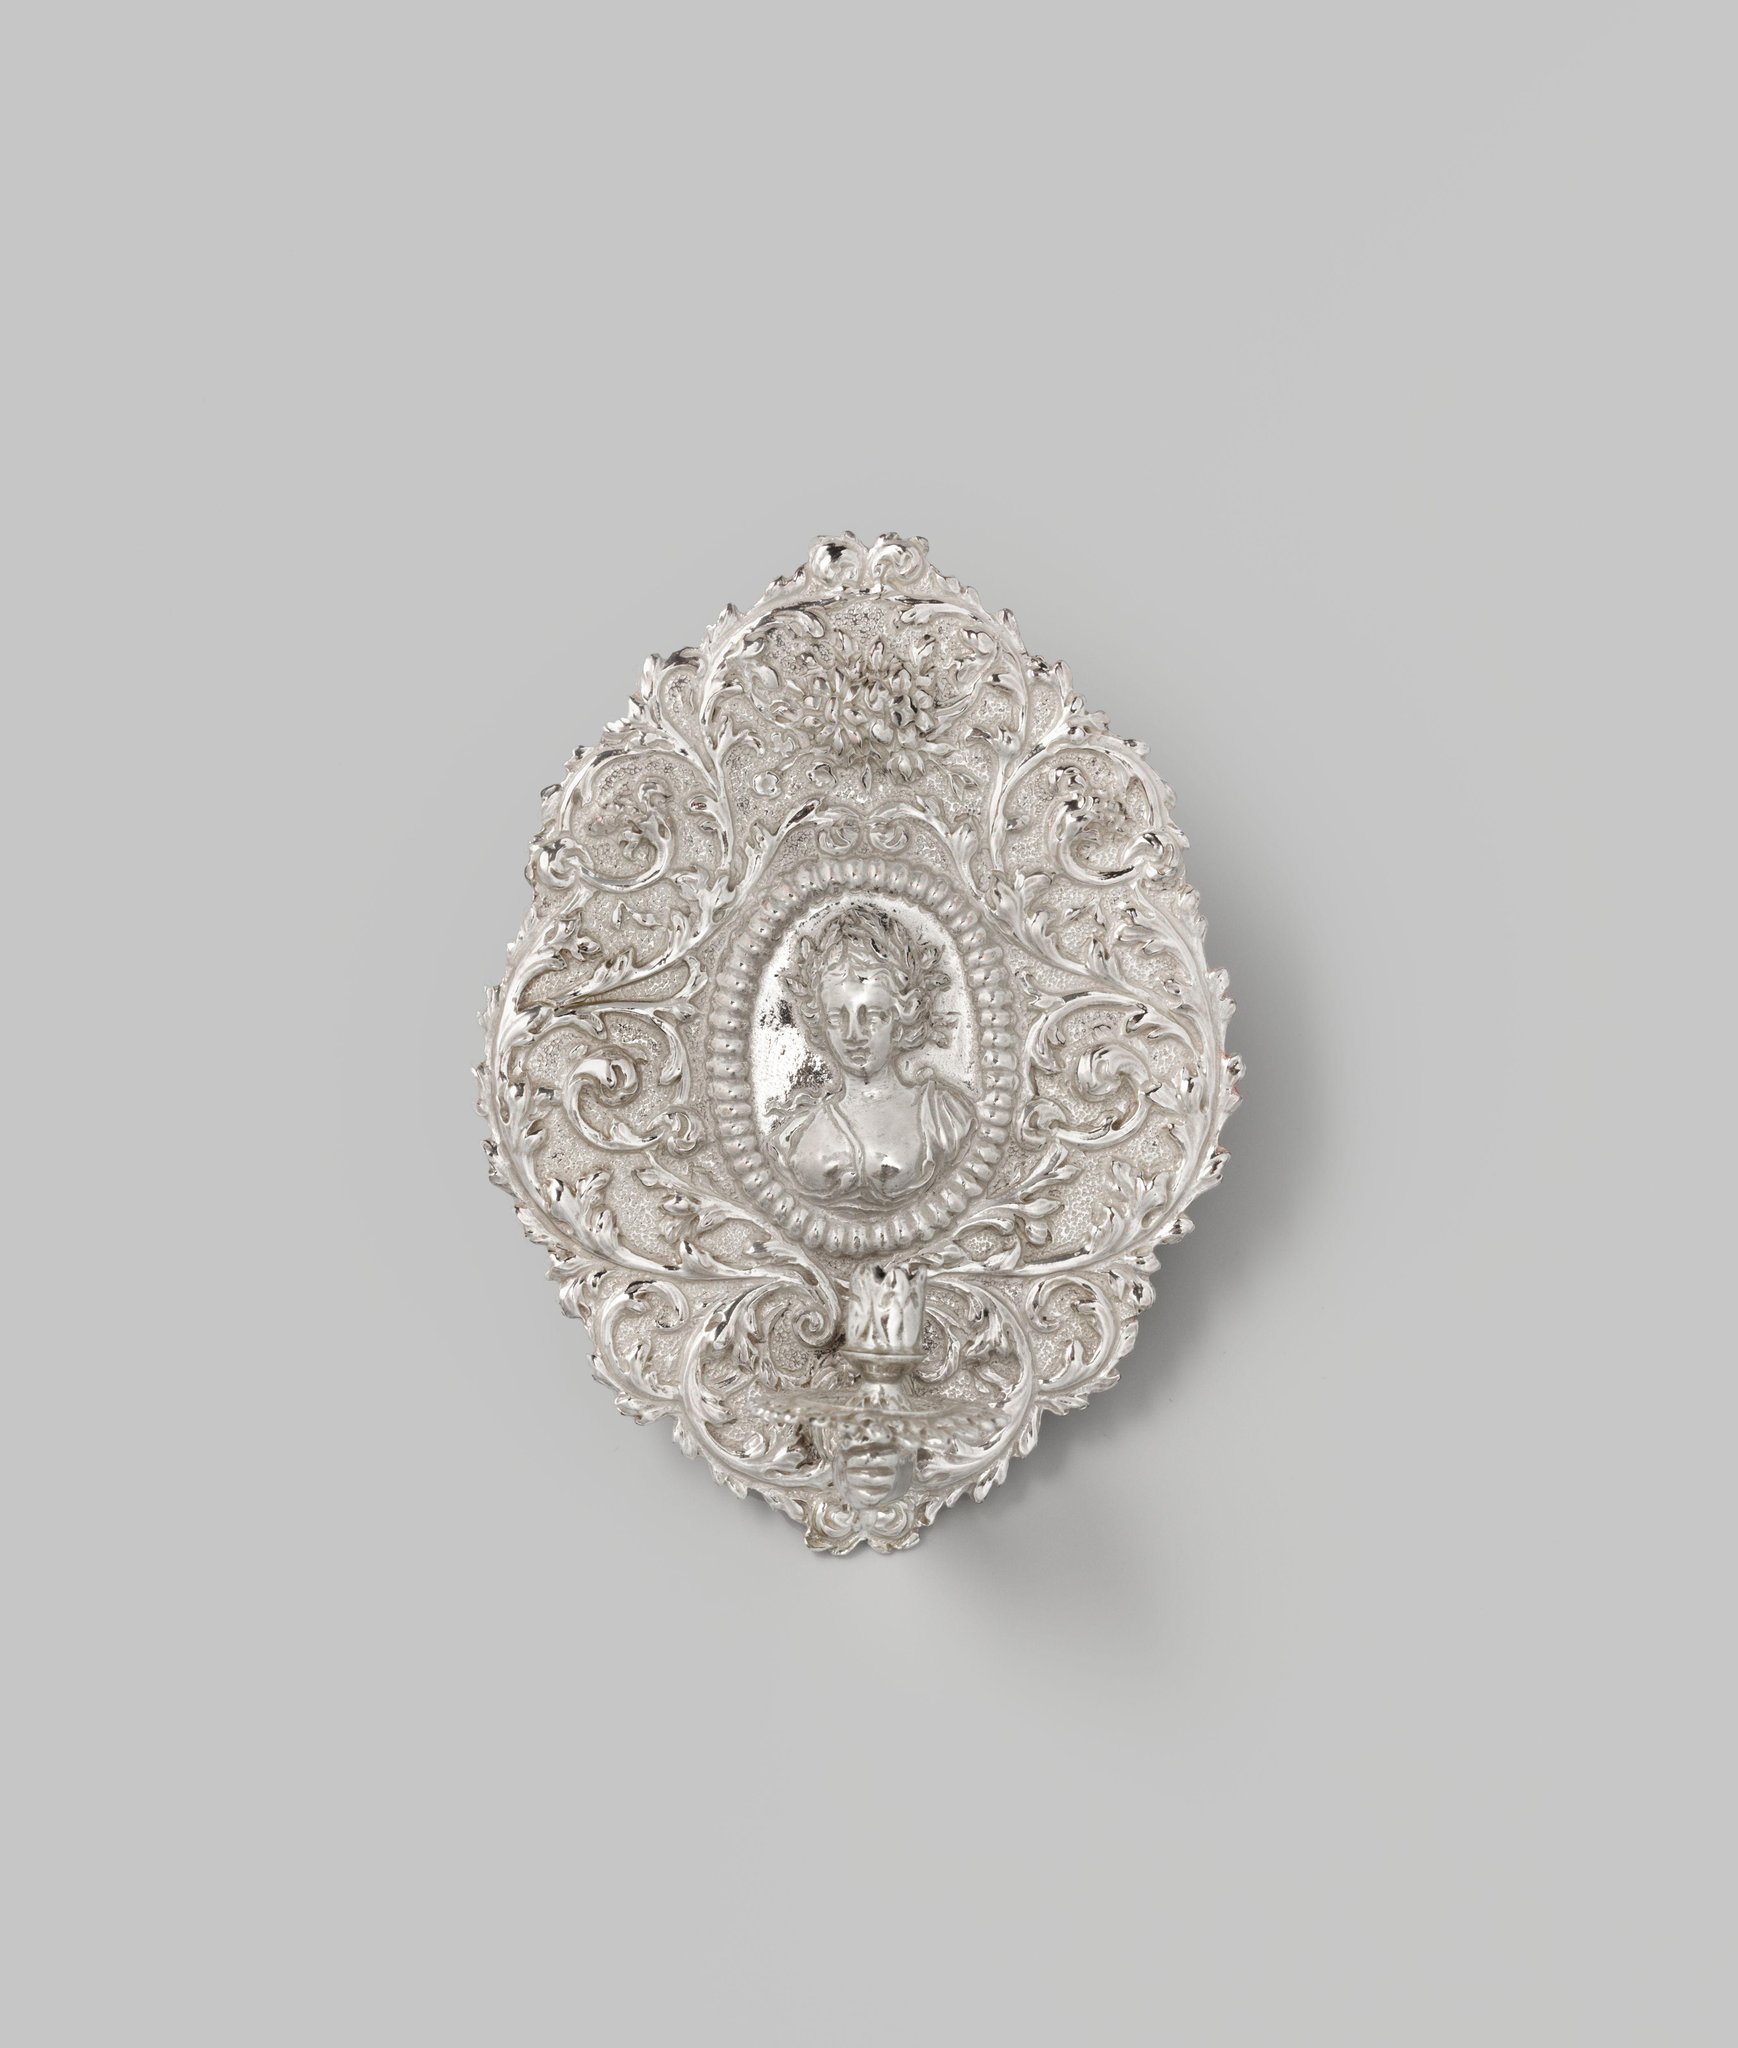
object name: miniature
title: Wandarm met personificatie van de zomer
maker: christiaan warenberg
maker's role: silversmith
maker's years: 1667-1747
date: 1700-1710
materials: silver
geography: amsterdam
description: Eén van vier zilveren wandarmen (BK-NM-1010-101-A t/m D), bestaande uit een spitsovaal wandschild, waarop gedreven een ovaal medaillon met vier verschillende borstbeelden voorstellende de vier seizoenen.